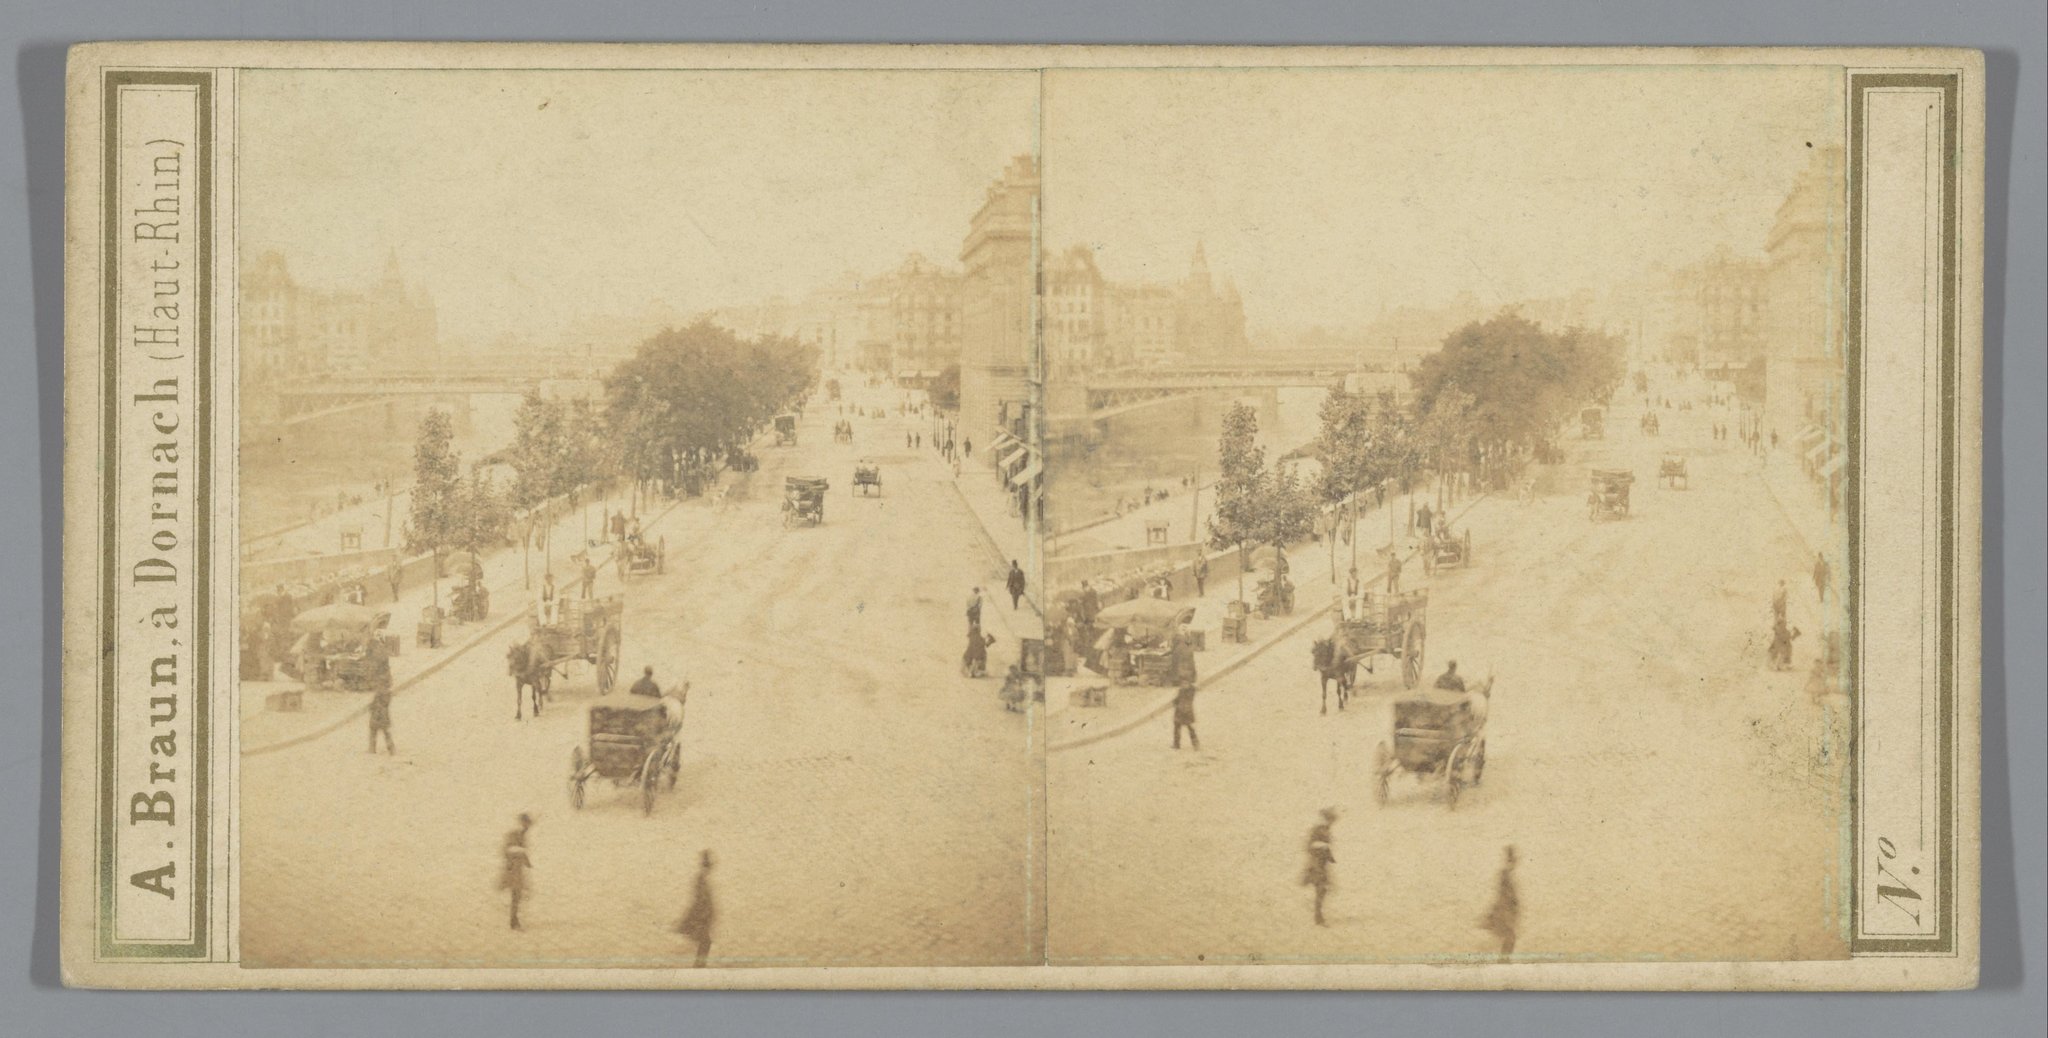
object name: stereograph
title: Paris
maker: Anonymous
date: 1860-1866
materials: cardboard, paper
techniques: albumen print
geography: paris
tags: street, paris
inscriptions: number: ‘No 1697.’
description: Titel op object is incorrect. De stereofoto toont een straat langs (vermoedelijk) de Seine in Parijs. De Fontaine Molière bevindt zich op de hoek tussen Rue Molière en Rue de Richelieu, het dichts bijzijnde water is vier straten naar het zuiden.